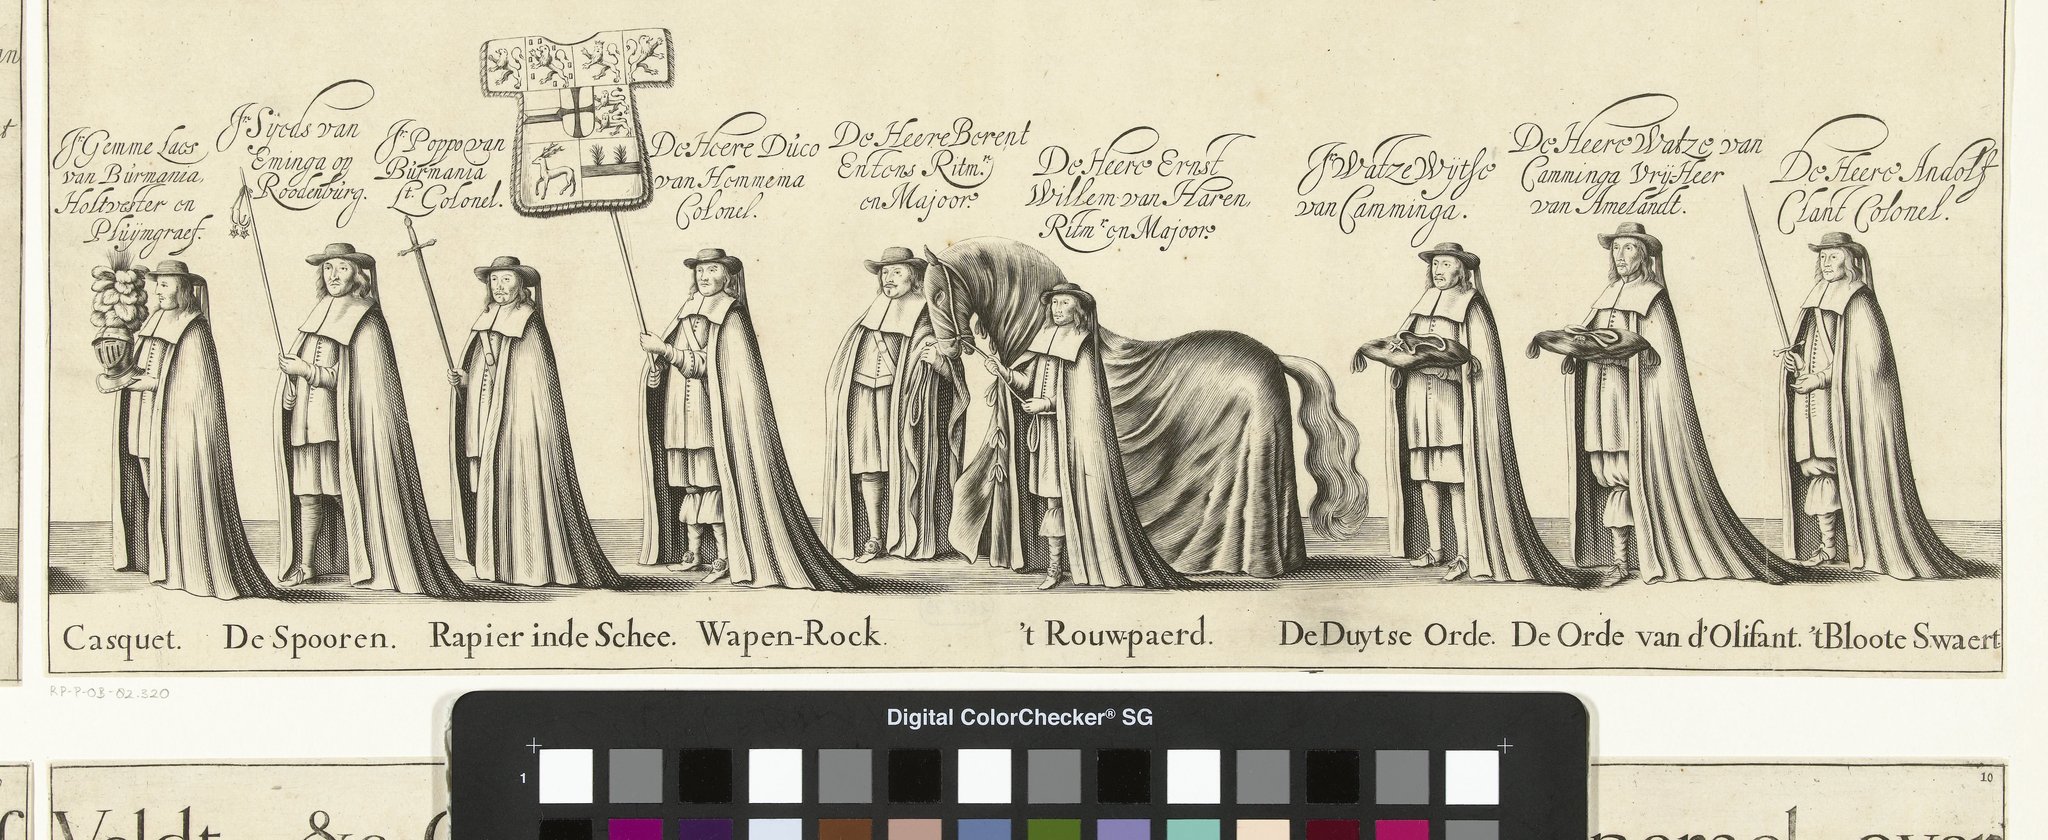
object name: print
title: Begrafenisoptocht van Willem Frederik, graaf van Nassau-Dietz (blad 8), 1665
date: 1666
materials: paper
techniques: engraving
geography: leeuwarden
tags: arnhem, cortege, funeral procession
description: Begrafenisoptocht van Willem Frederik, graaf van Nassau-Dietz, in Leeuwarden op 6 januari 1665. Deel van de begrafenisstoet. Plaat nr. 8 in een ensemble van 24 (van de 25) ongemonteerde genummerde platen (zonder tekstbladen) die samen een lange fries vormen.